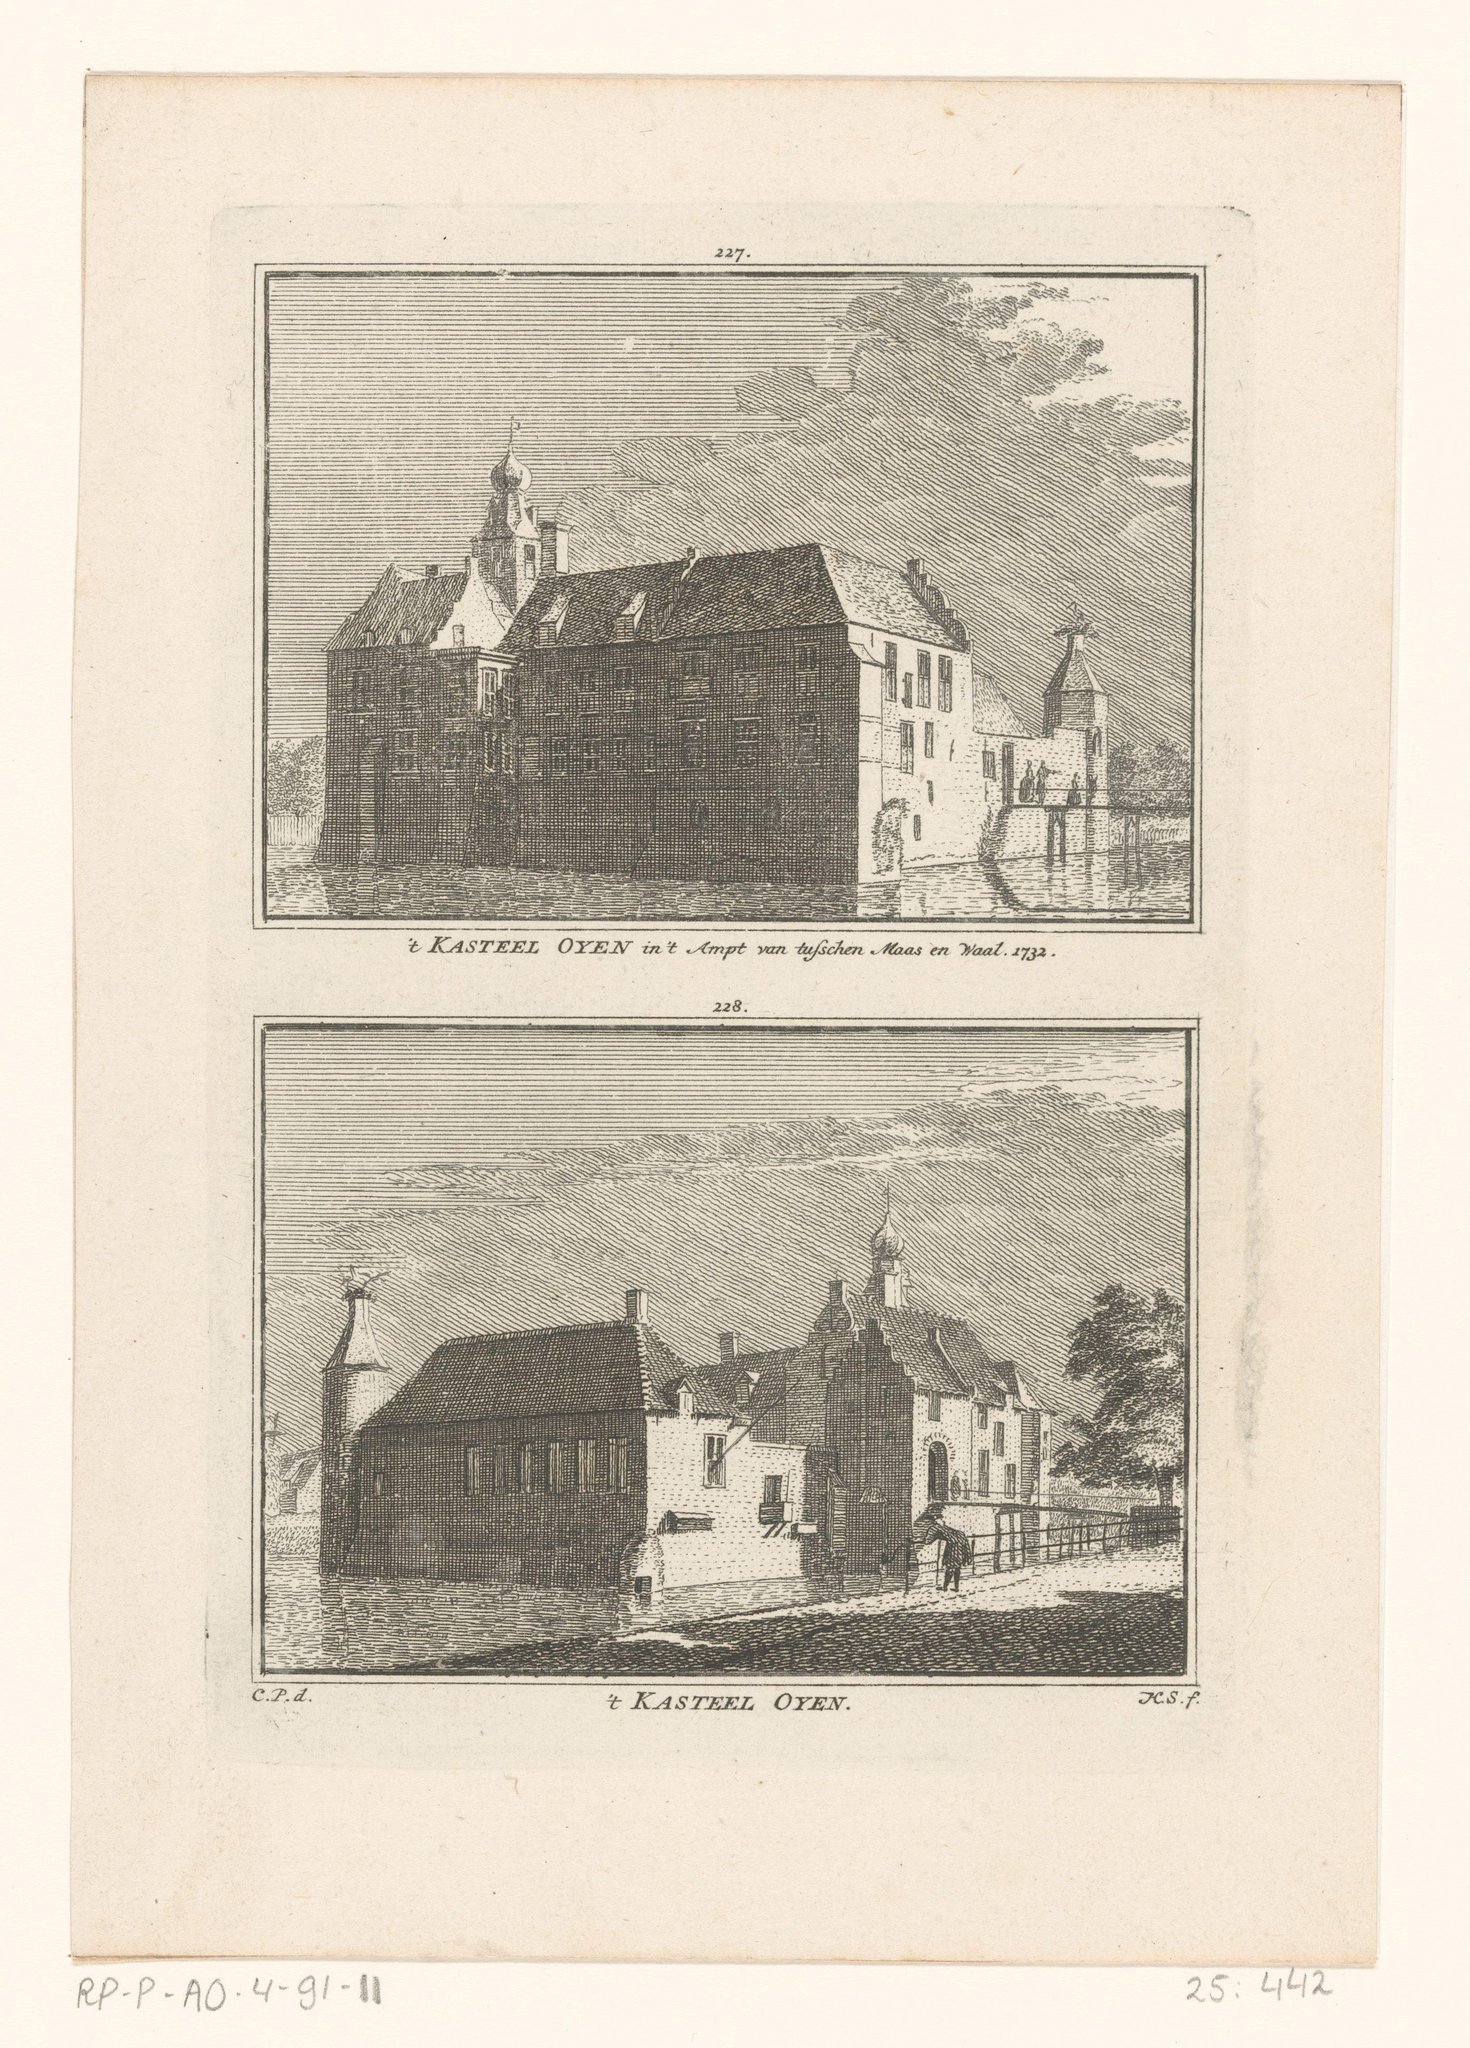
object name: print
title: 't Kasteel Oyen in 't ampt van tusschen Maas en Waal. 1732 / 't Kasteel Oyen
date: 1750-1792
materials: paper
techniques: etching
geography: haarlem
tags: castle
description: Prent ook gebruikt in: Het verheerlykt Nederland of kabinet van hedendaagsche gezigten van steden, dorpen (…). 9 delen. Amsterdam: Isaak Tirion en weduwe Isaak Tirion, 1745-1774, dl. 3 (1750), ill. 227-228. Of in: Nederlandsche tafereelen; of eene keurige verzameling van negen honderd fraaije gezigten van steden, dorpen, sloten, oudheden (….). 9 delen. Amsterdam: Jan de Groot, 1792, dl. 3, ill. 227-228.